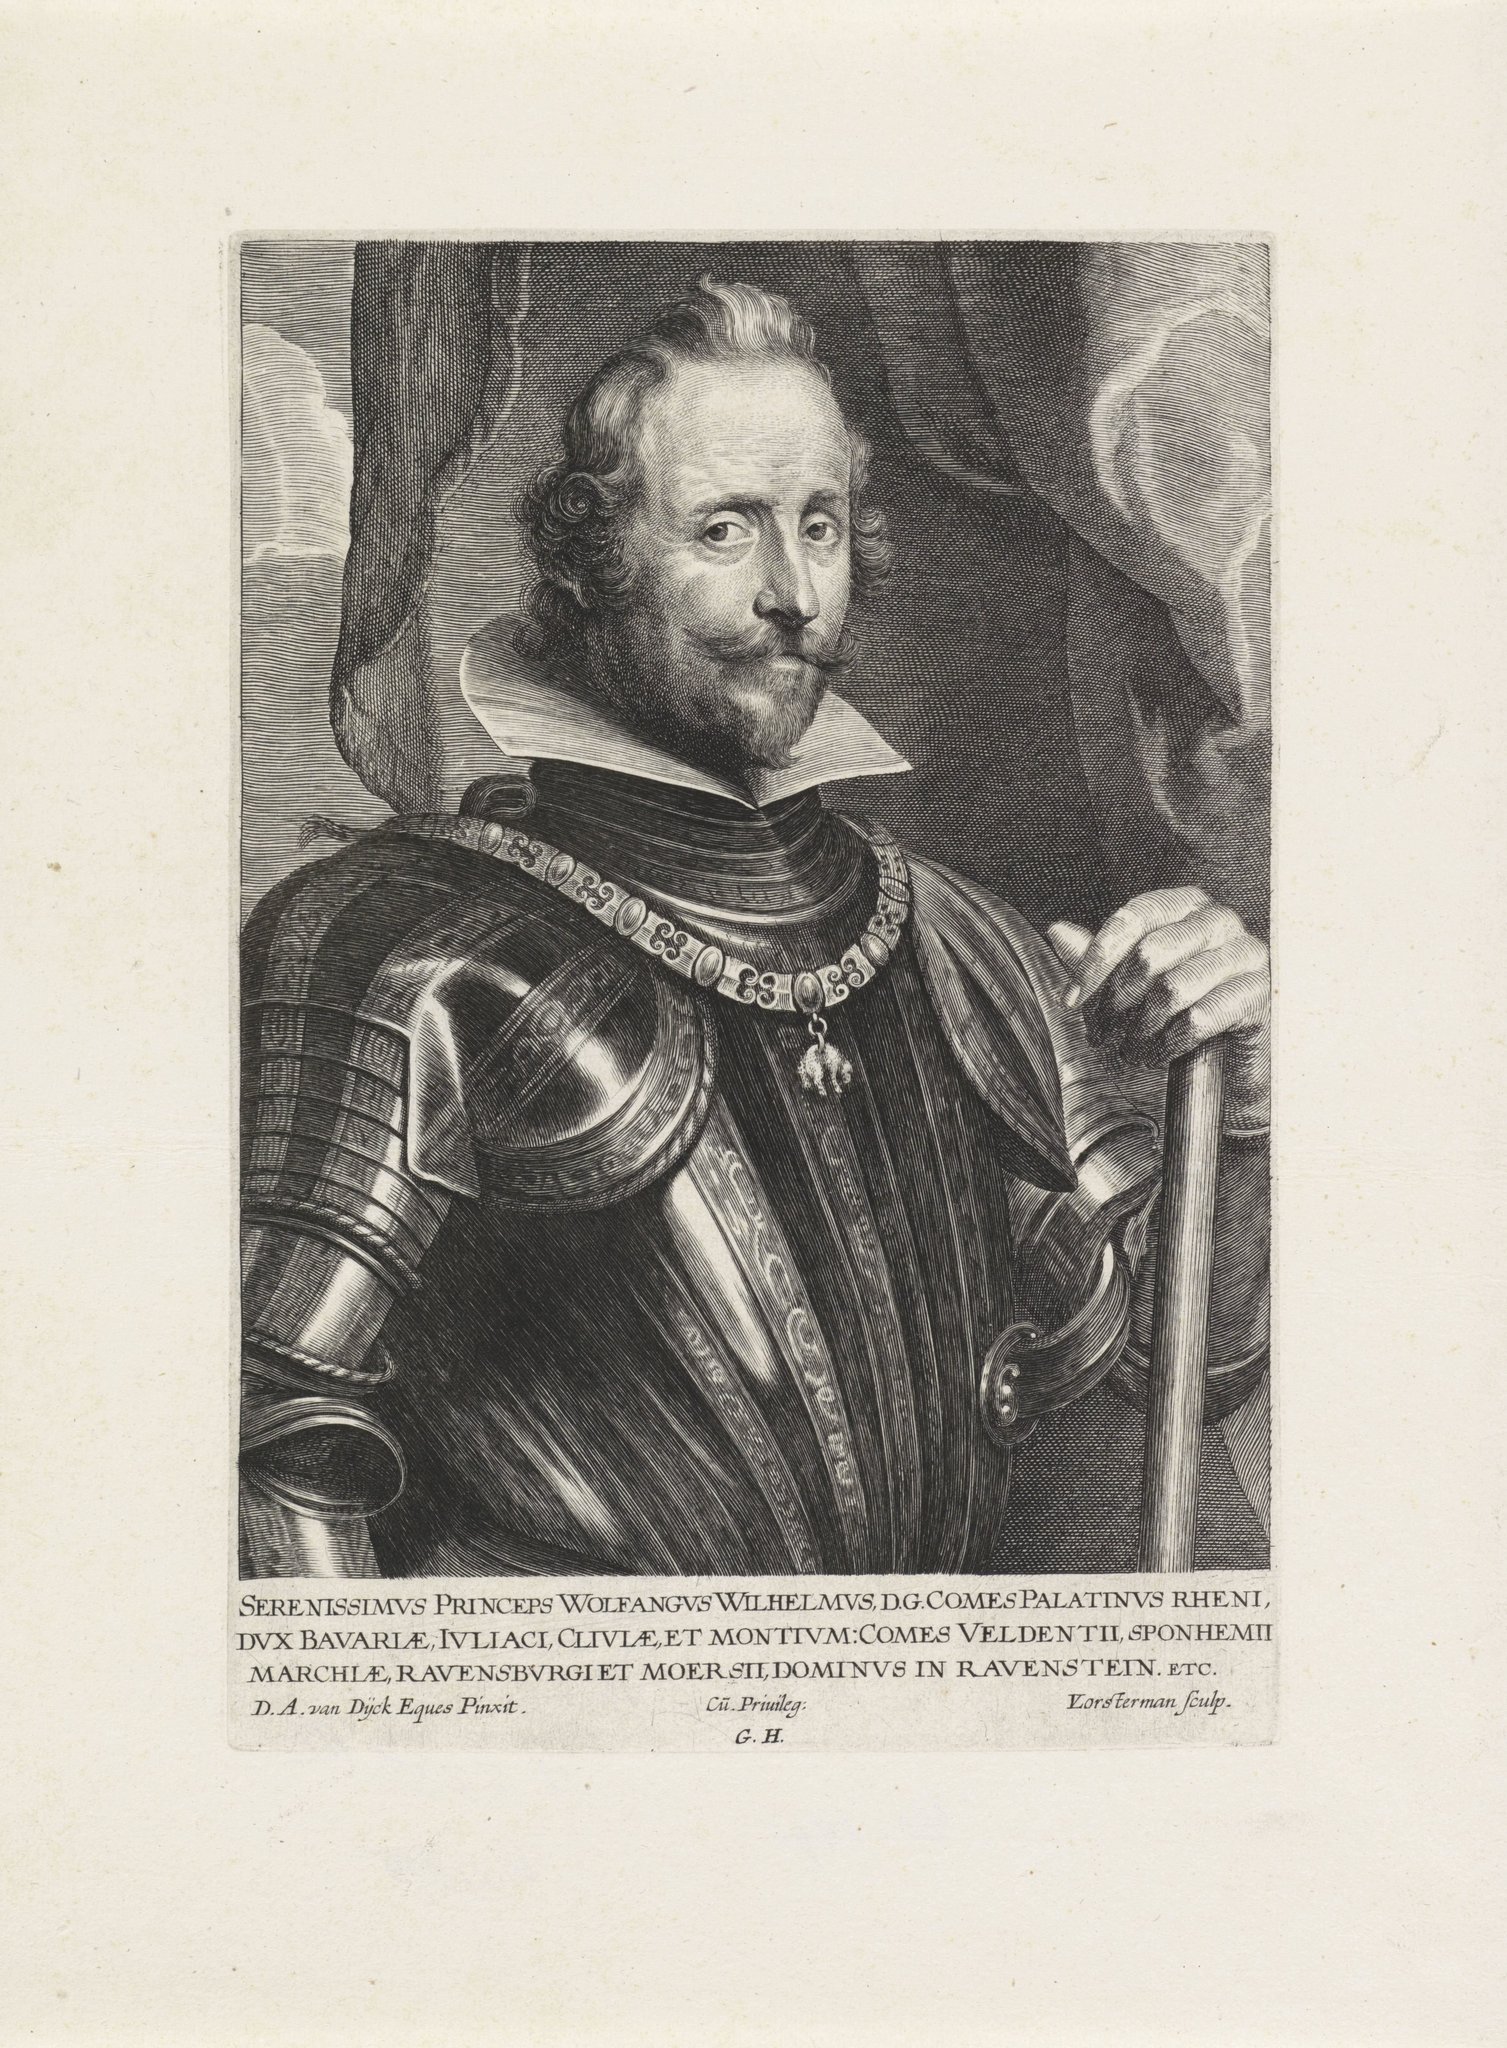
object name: print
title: Iconographie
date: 1645-1646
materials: paper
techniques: engraving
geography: antwerp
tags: wolfgang willem van de palts-neuburg, armour, knighthood order of the golden fleece, baton of general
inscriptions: collector's mark: Lugt 2760, collector's mark: Lugt 2166, collector's mark: Lugt 2228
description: Prent gebruikt voor: Icones principum, virorum doctorum, pictorum, chalcographorum, statuariorum nec non amatorum pictoriae artis numero centum ab Ant. van Dyck ad vivum expressae ejusque sumptibus aeri incisae. Antwerpen: Gillis Hendricx, [1645-1646].